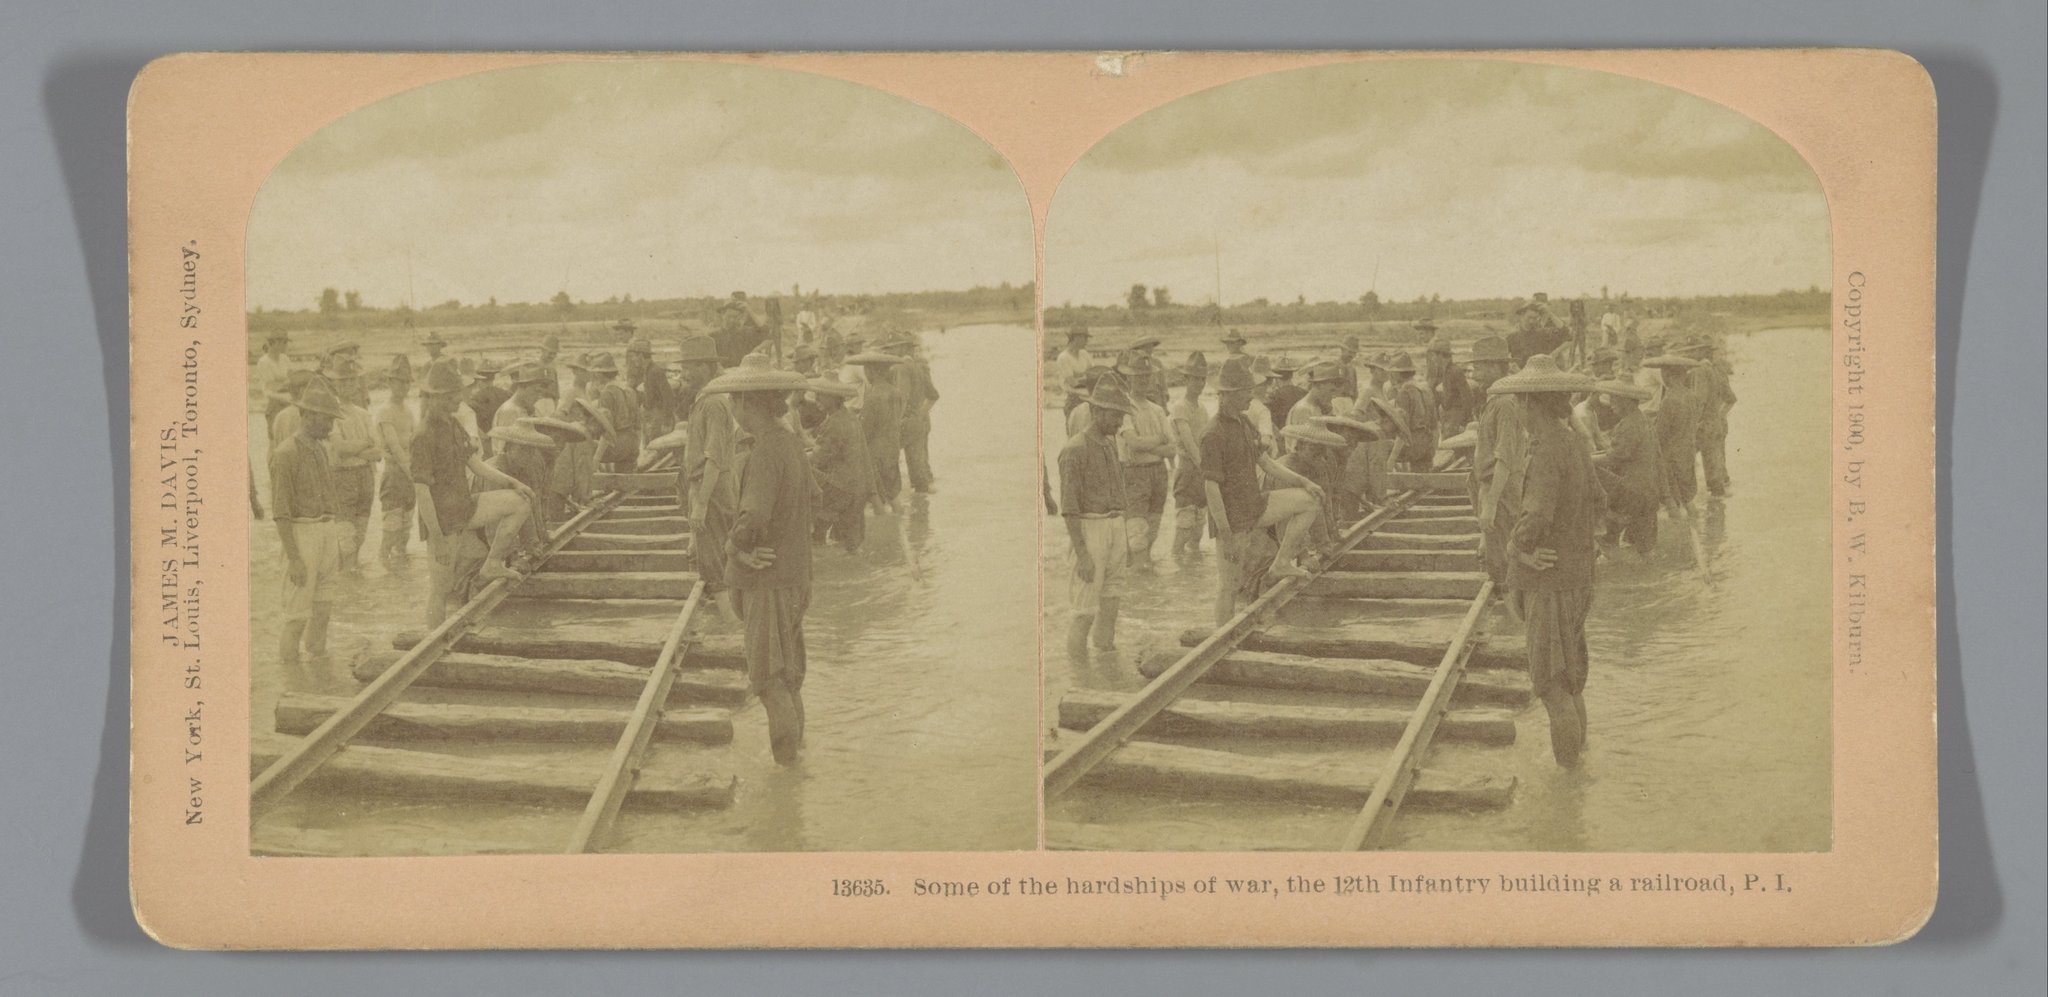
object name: stereograph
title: Some of the hardships of war, the 12th Infantry building a railroad, P.I.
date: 1900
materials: cardboard, paper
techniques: albumen print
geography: philadelphia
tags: railway, train, philippines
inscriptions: copyright notice: ‘Copyright 1900, by B. W. Kilburn.’, number: ‘13635’